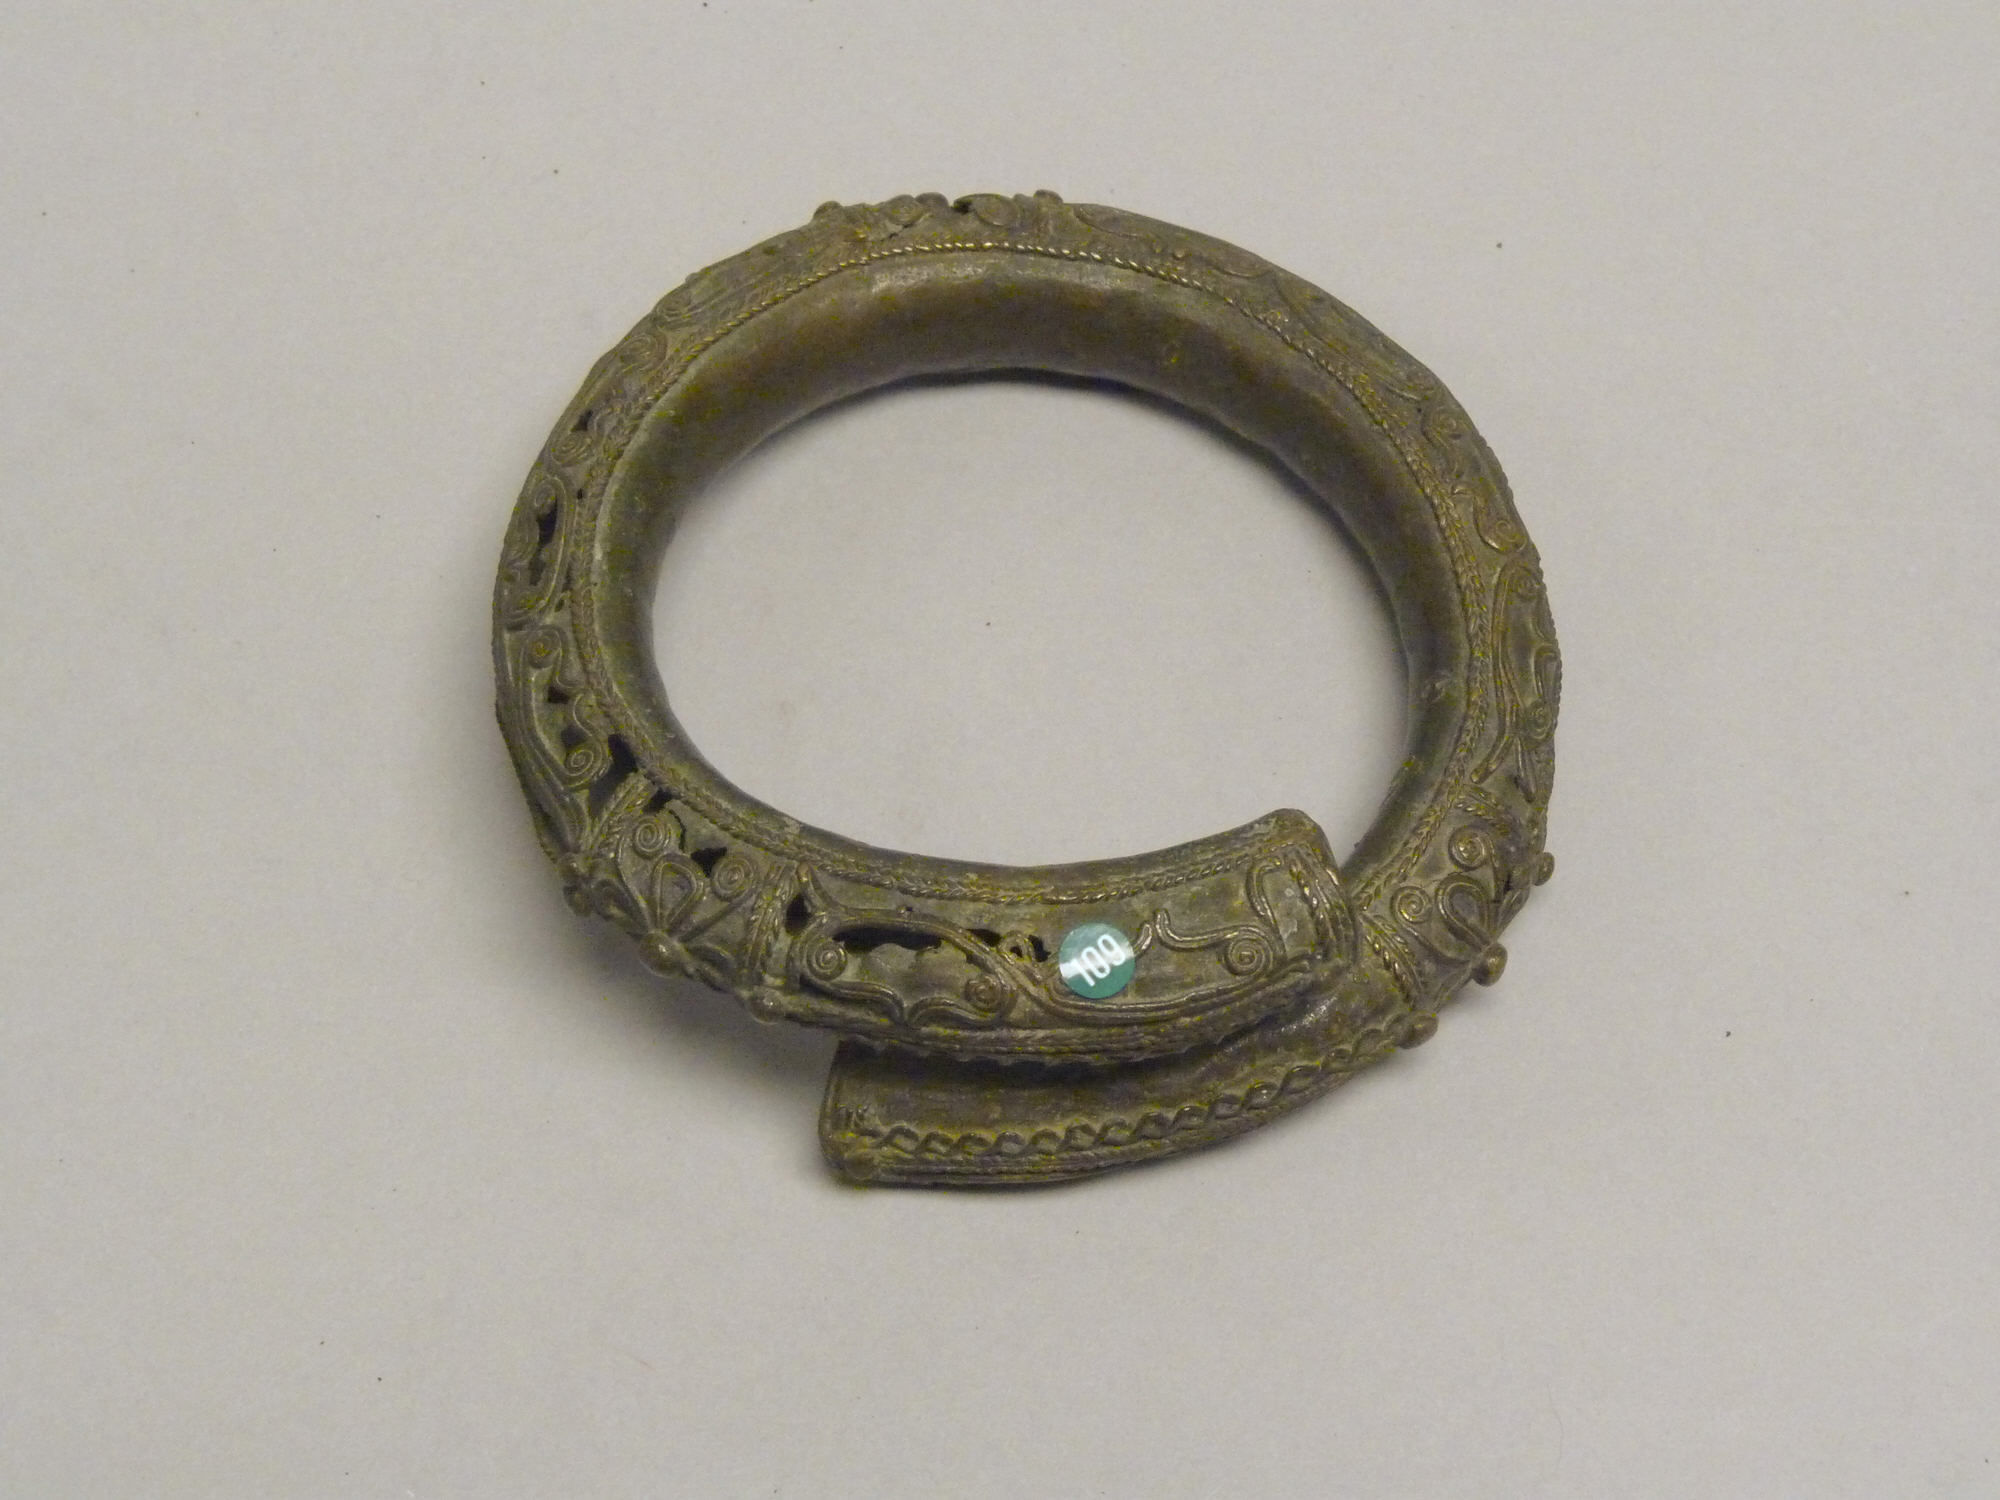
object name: anklet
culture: thai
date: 500 BCE-300 CE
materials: bronze